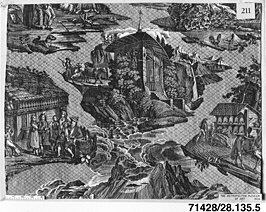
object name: piece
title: Swiss scenes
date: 1820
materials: cotton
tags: animals,houses,men,women